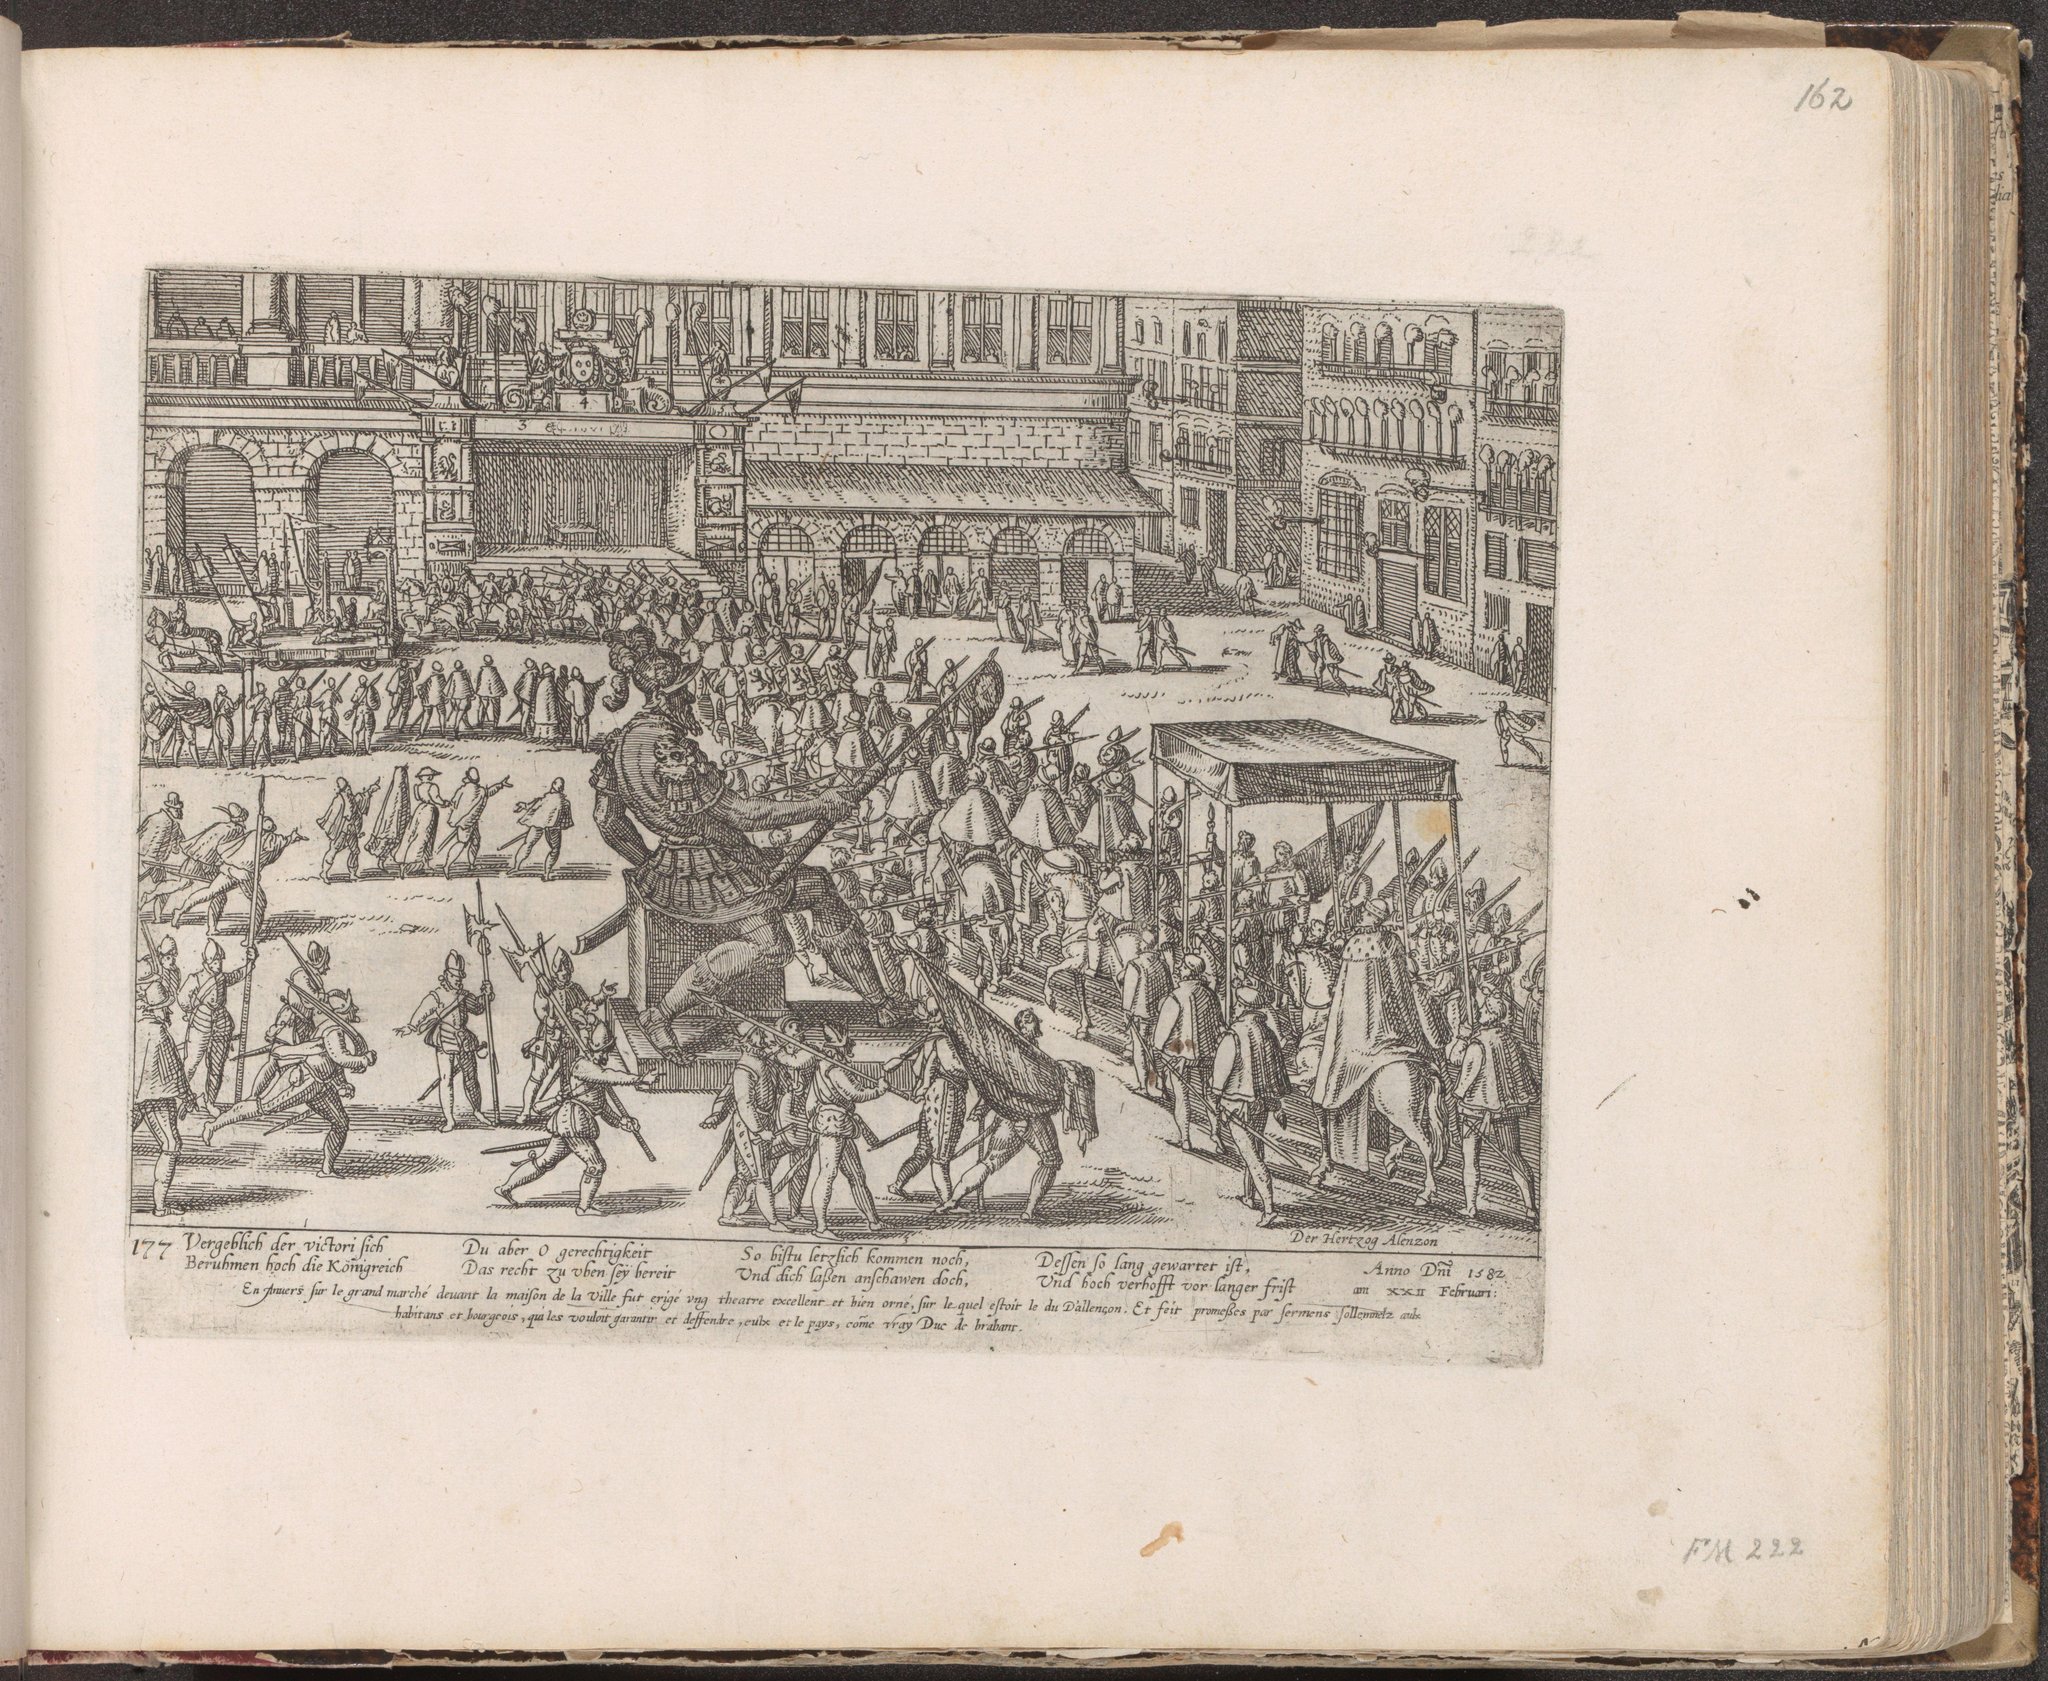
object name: print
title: Serie 8: Nederlandse Gebeurtenissen, 1577-1583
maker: frans hogenberg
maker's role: print maker, publisher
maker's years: 1538-1590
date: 1582-1585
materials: paper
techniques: etching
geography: cologne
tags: paris, françois-hercule de valois (hertog van anjou), triumphal entry and public reception, pageant, 'entrée solennelle', 'joyeuse entrée', antwerp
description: Feestelijke intocht van Anjou te Antwerpen, 22 februari 1582. De stoet met de hertog komt op de Grote Markt waar een beeld van de reus Druon opgesteld staat. Met onderschrift van 8 regels in het Duits en 2 regels in het Frans. Linksonder genummerd: 177. De prent maakt deel uit van een album.